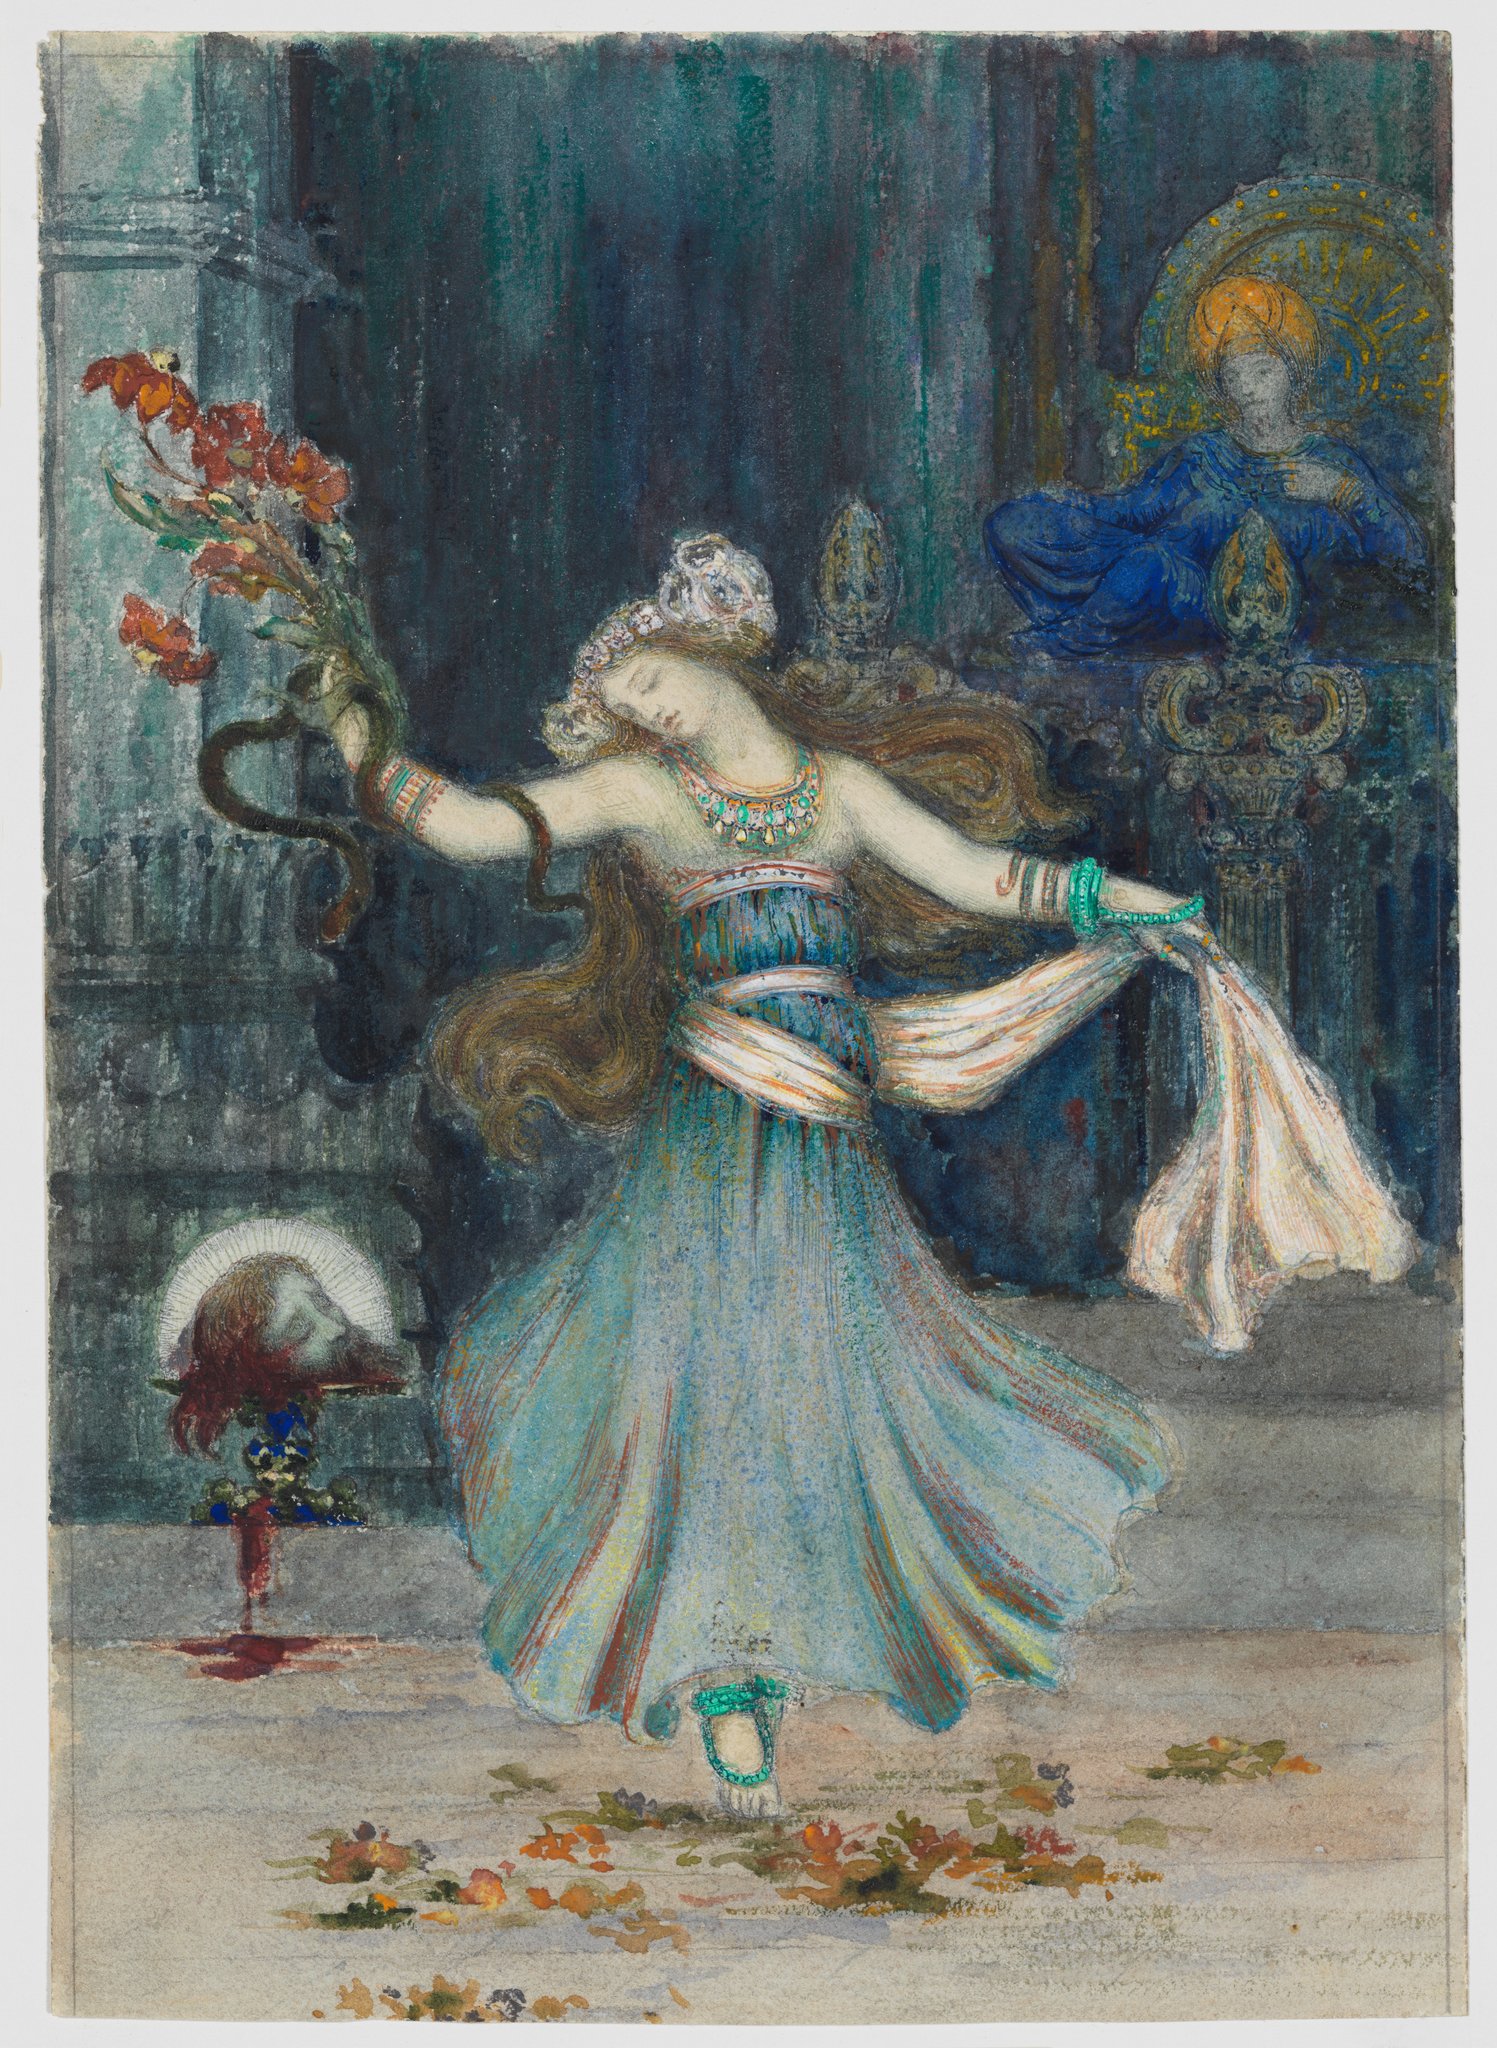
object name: drawing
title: Salomé Dancing Before the Head of St. John the Baptist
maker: gustave moreau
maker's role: artist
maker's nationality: french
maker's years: 1826-1898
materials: gouache, graphite, watercolor, paper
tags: heads,women,dancing,saint john the baptist,salome